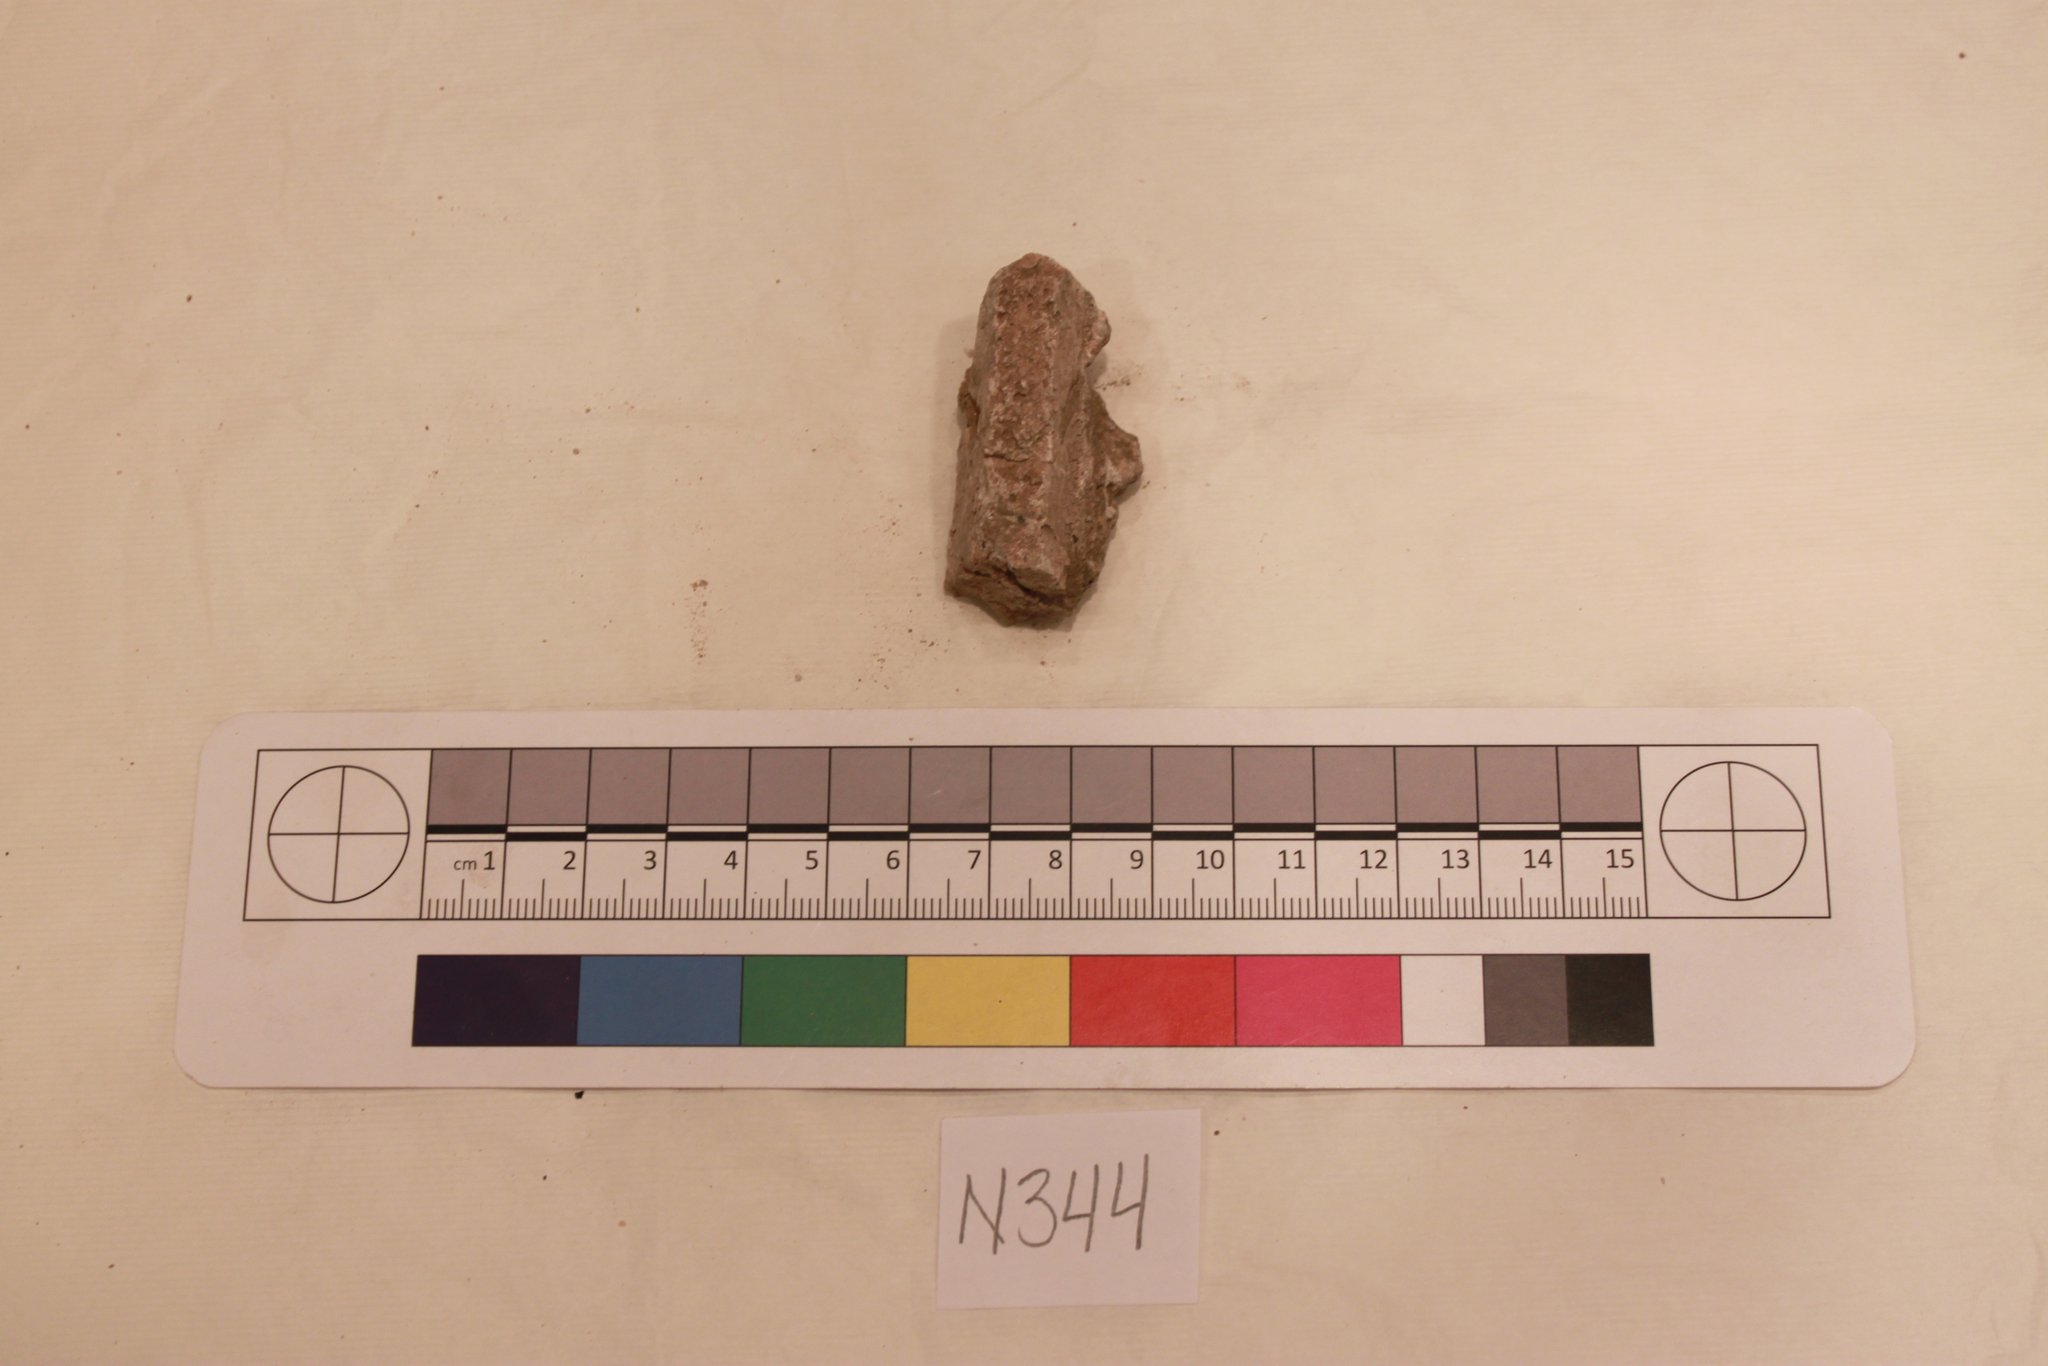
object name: fragment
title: Stucco Fragment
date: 701-1200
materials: plaster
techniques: carving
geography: iran